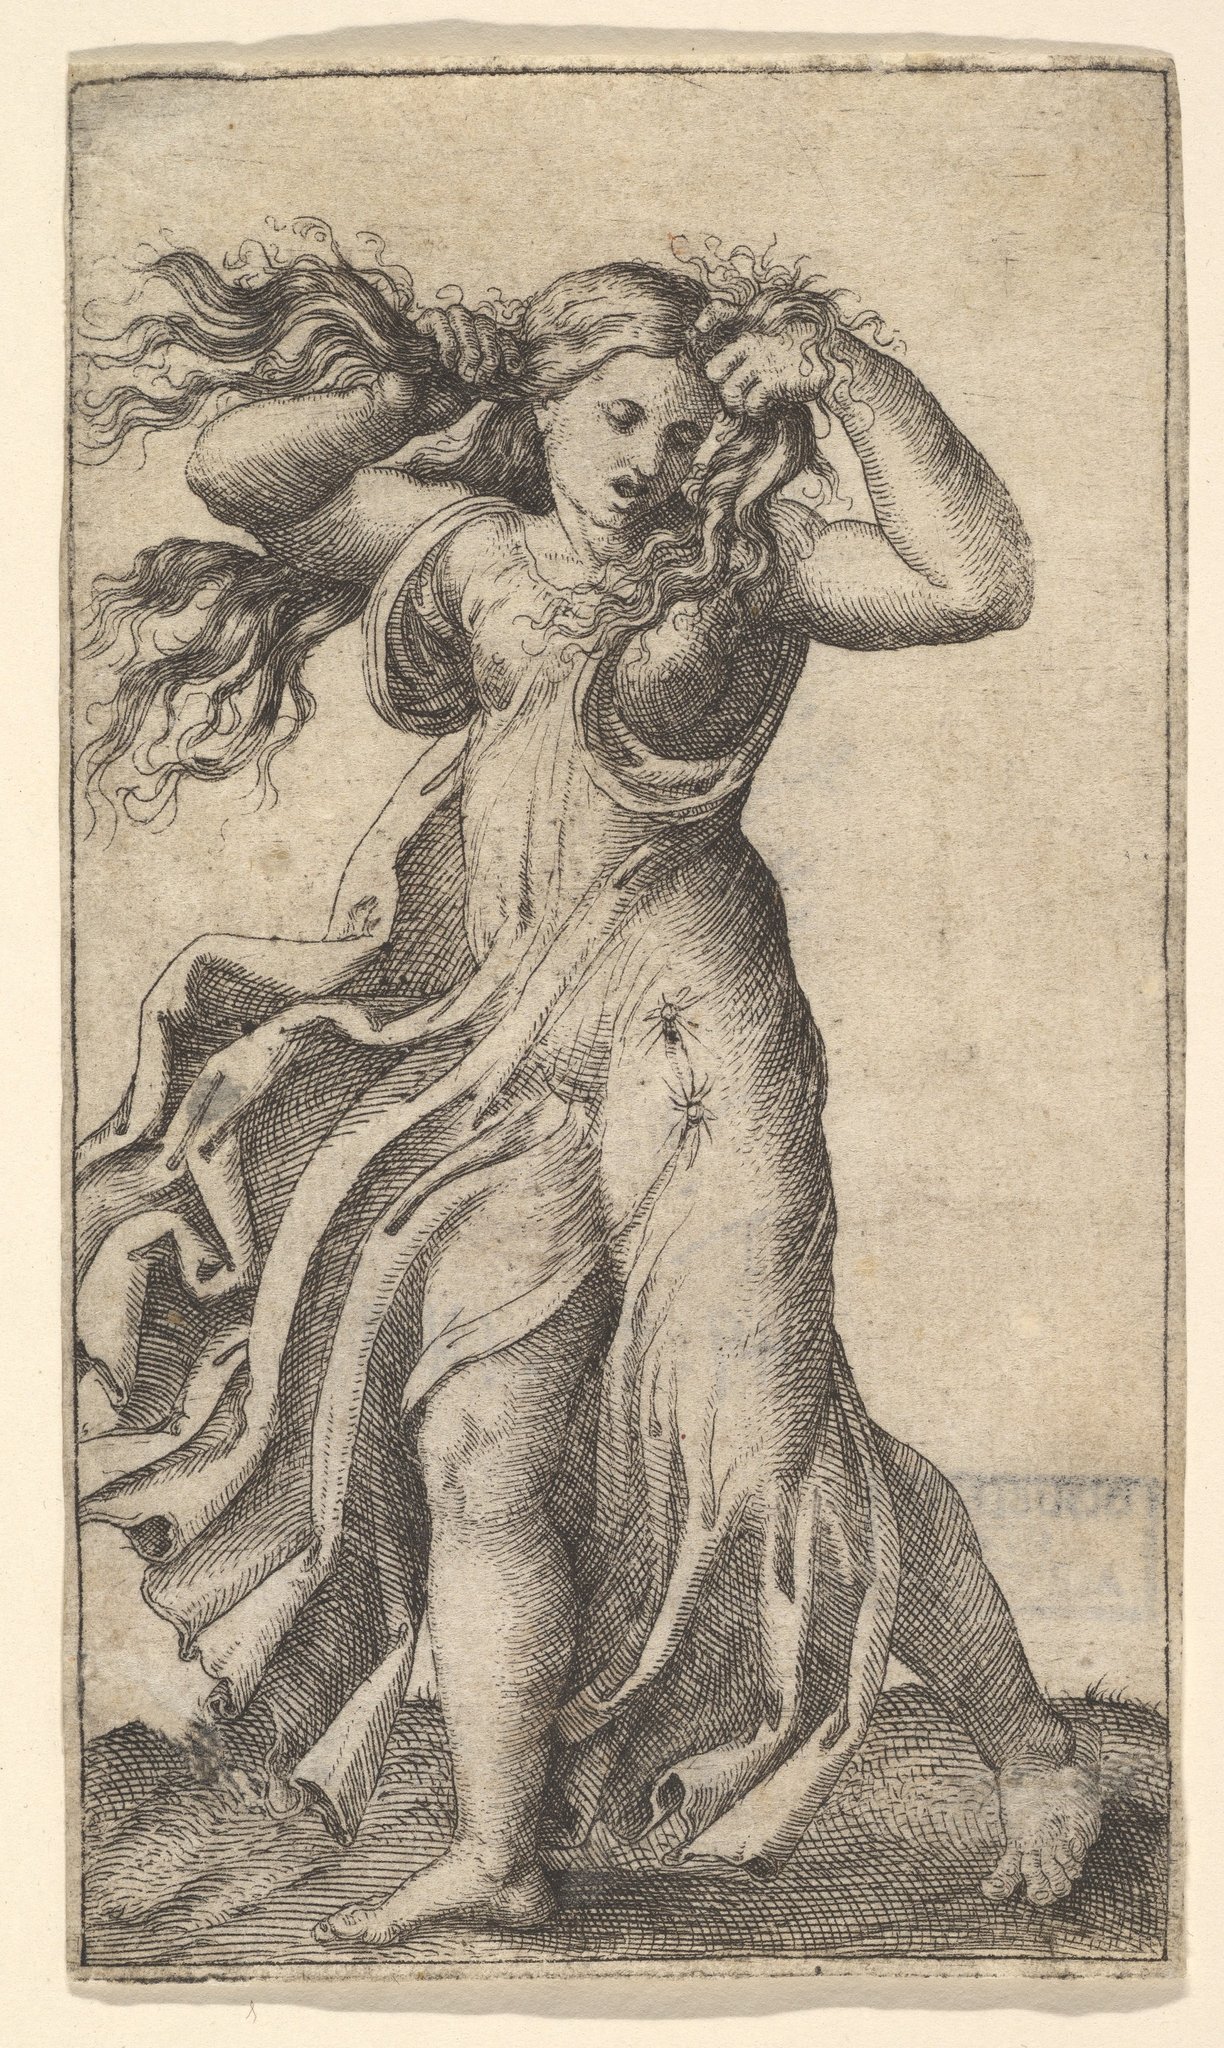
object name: print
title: Woman pulling Her Hair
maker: marcantonio raimondi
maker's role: artist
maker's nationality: italian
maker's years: 1475-1534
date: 1515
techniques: drypoint, engraving, etching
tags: hair,women